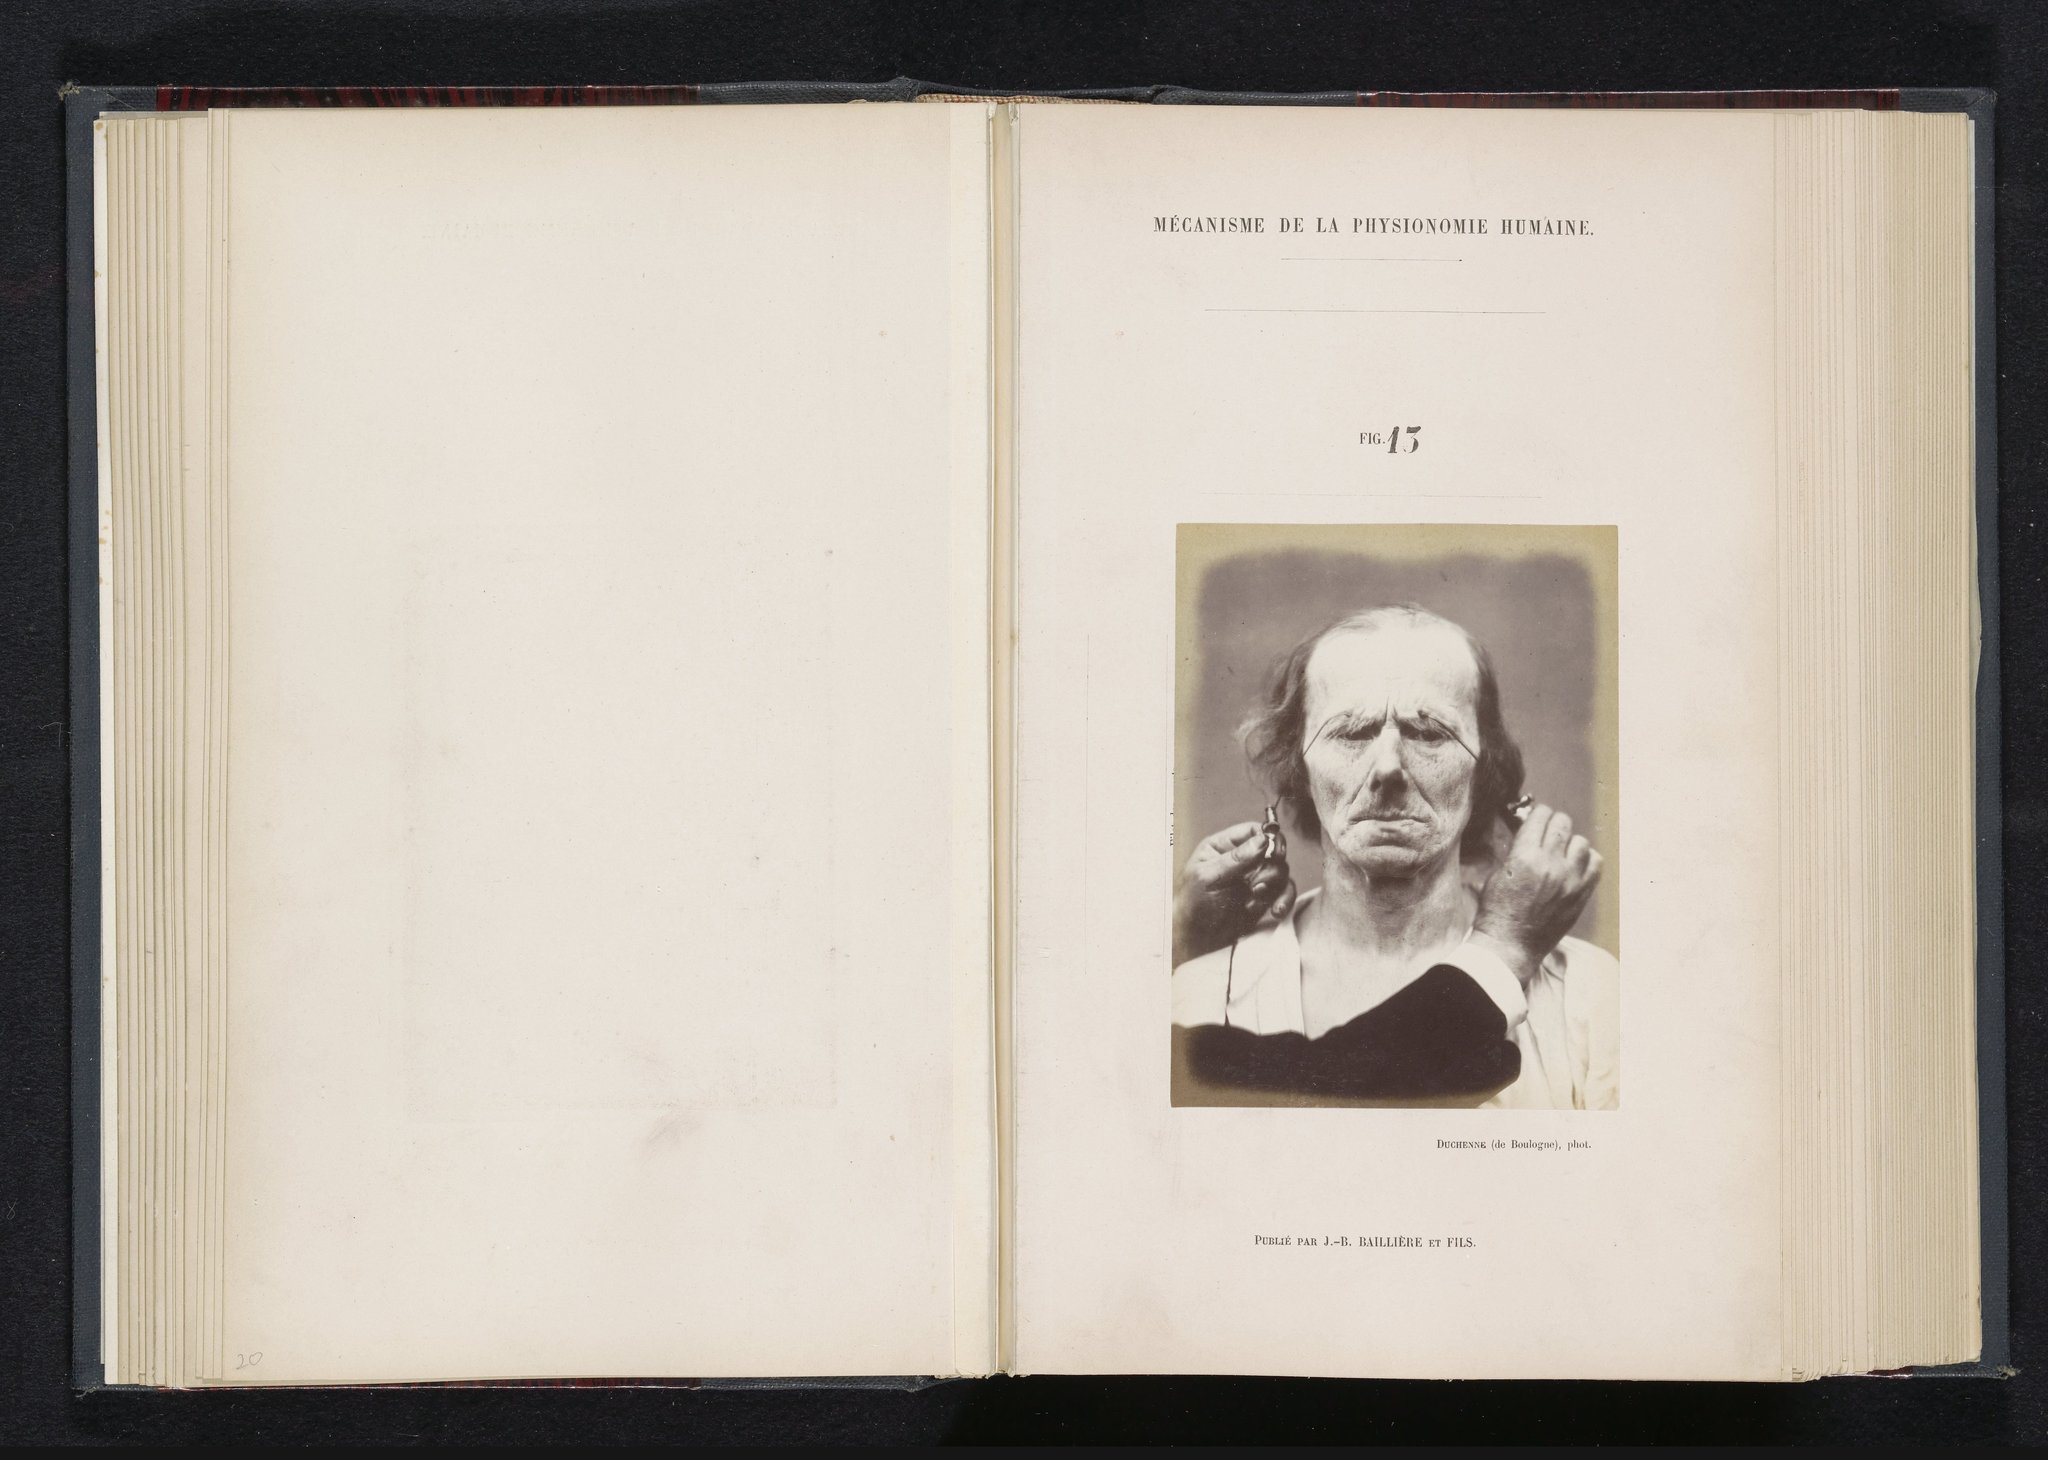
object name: page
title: Portret van een proefpersoon tijdens elektrostimulatie: 'un vieillard'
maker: guillaume benjamin amand duchenne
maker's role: fotograaf, medicus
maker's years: 1806-1875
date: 1860-1862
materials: paper, photographic support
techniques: albumen print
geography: paris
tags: face, physiology and anatomy ~ nervous system, neurology, physiology and anatomy, old man, morphology of facial expression, physiognomy, experiment, test ~ science and technology, france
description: Ongenummerde pagina met foto 13 uit Mécanisme de la physionomie humaine ou analyse électro-physiologique de l'expression des passions (Atlas).